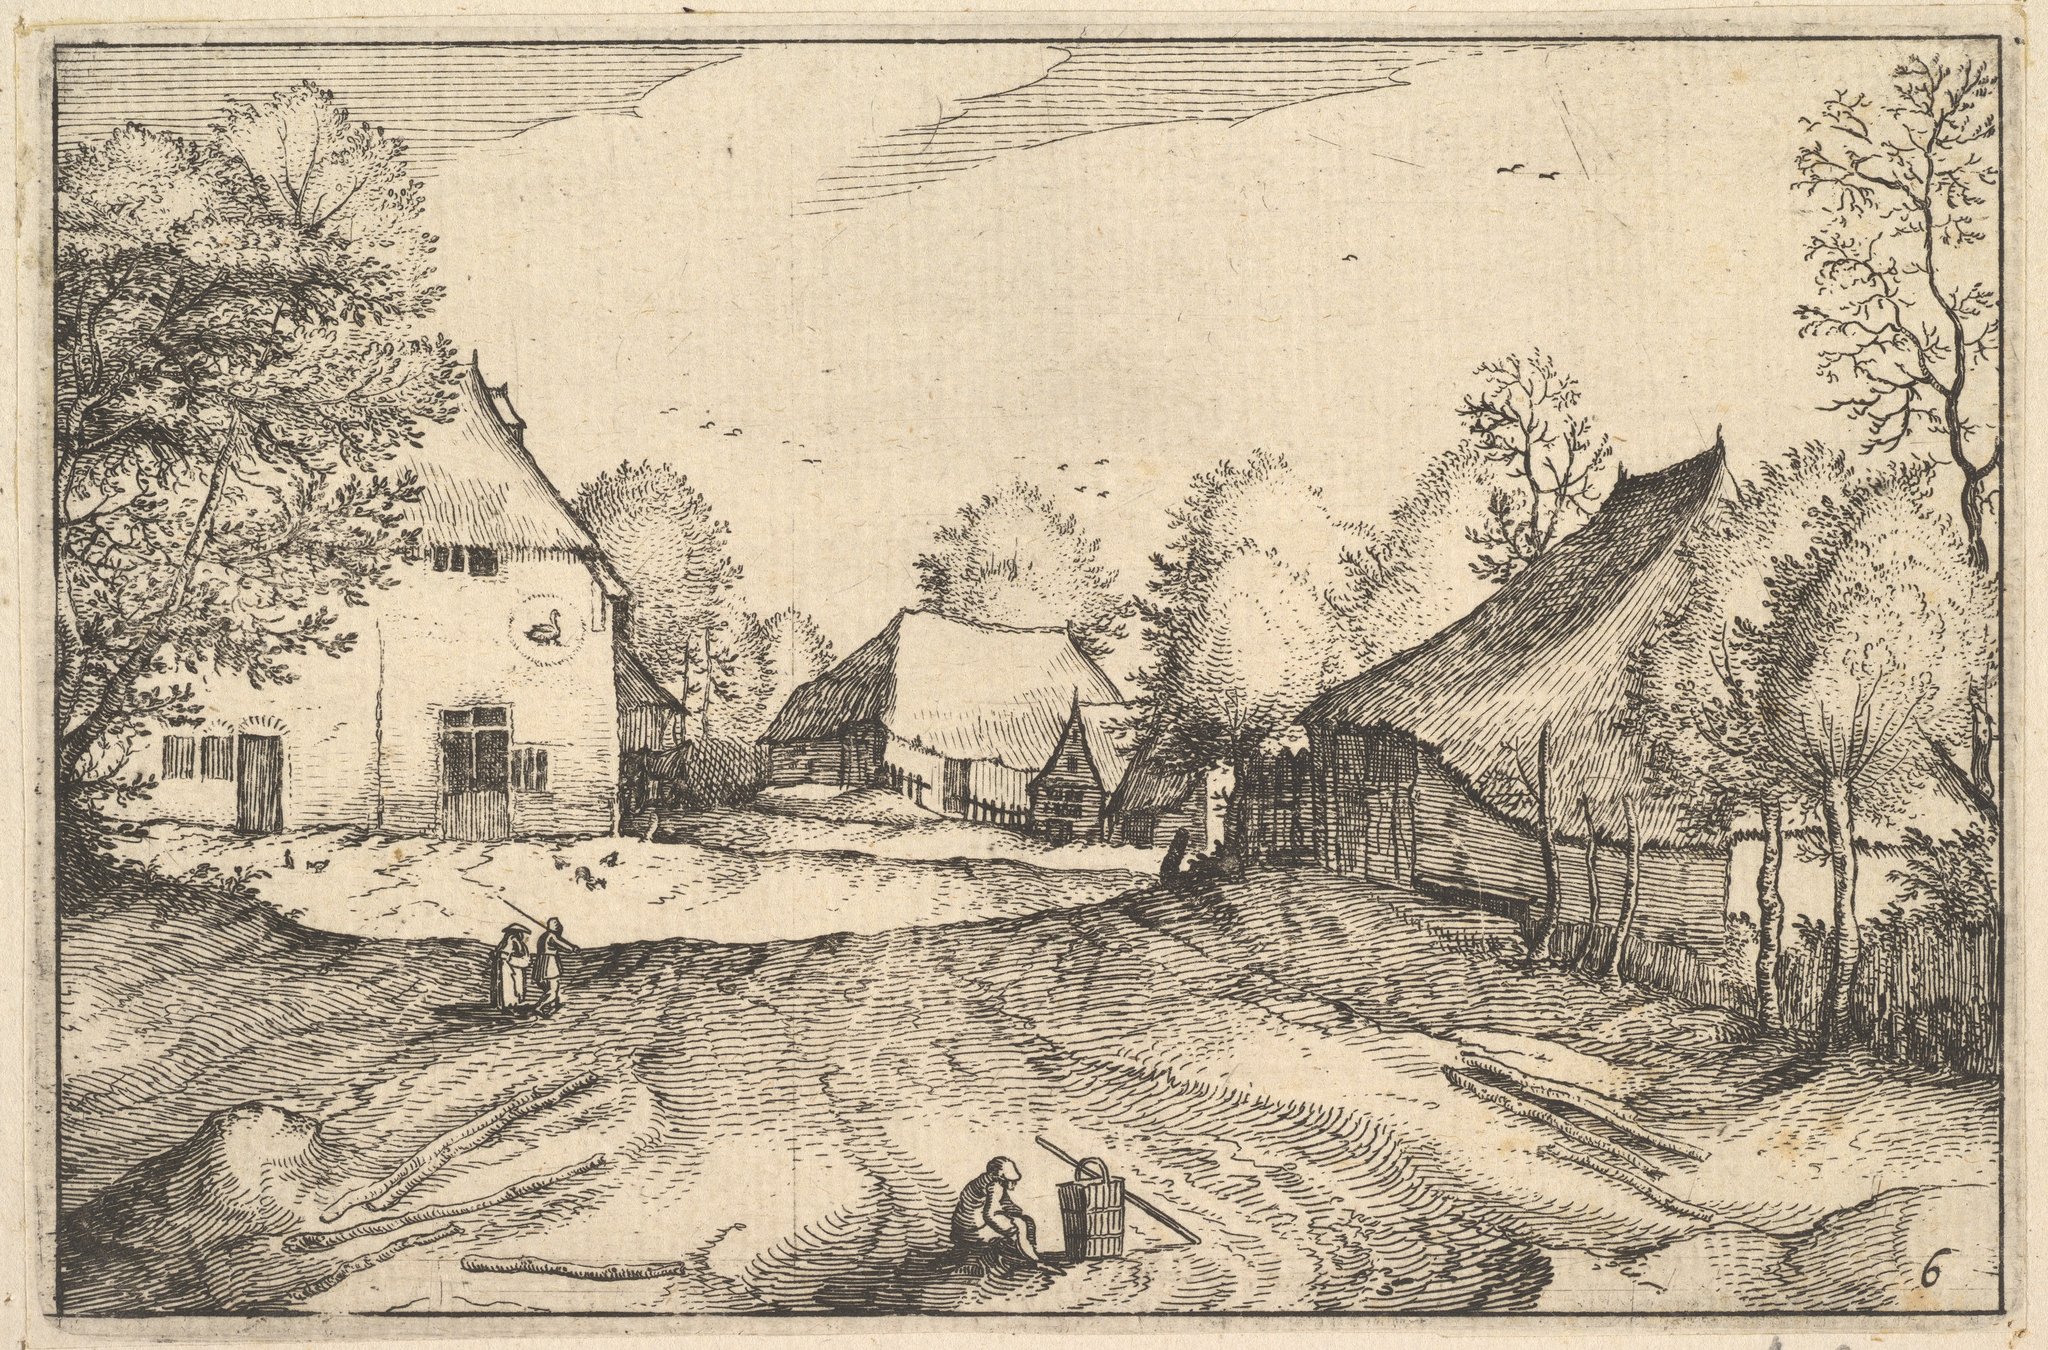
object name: print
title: The Swan's Inn, plate 6 from "Regiunculae et Villae Aliquot Ducatus Brabantiae"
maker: claes jansz. visscher (ii)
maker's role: artist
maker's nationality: dutch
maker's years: 1586-1652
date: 1610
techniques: etching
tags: houses,towns,men,landscapes,trees